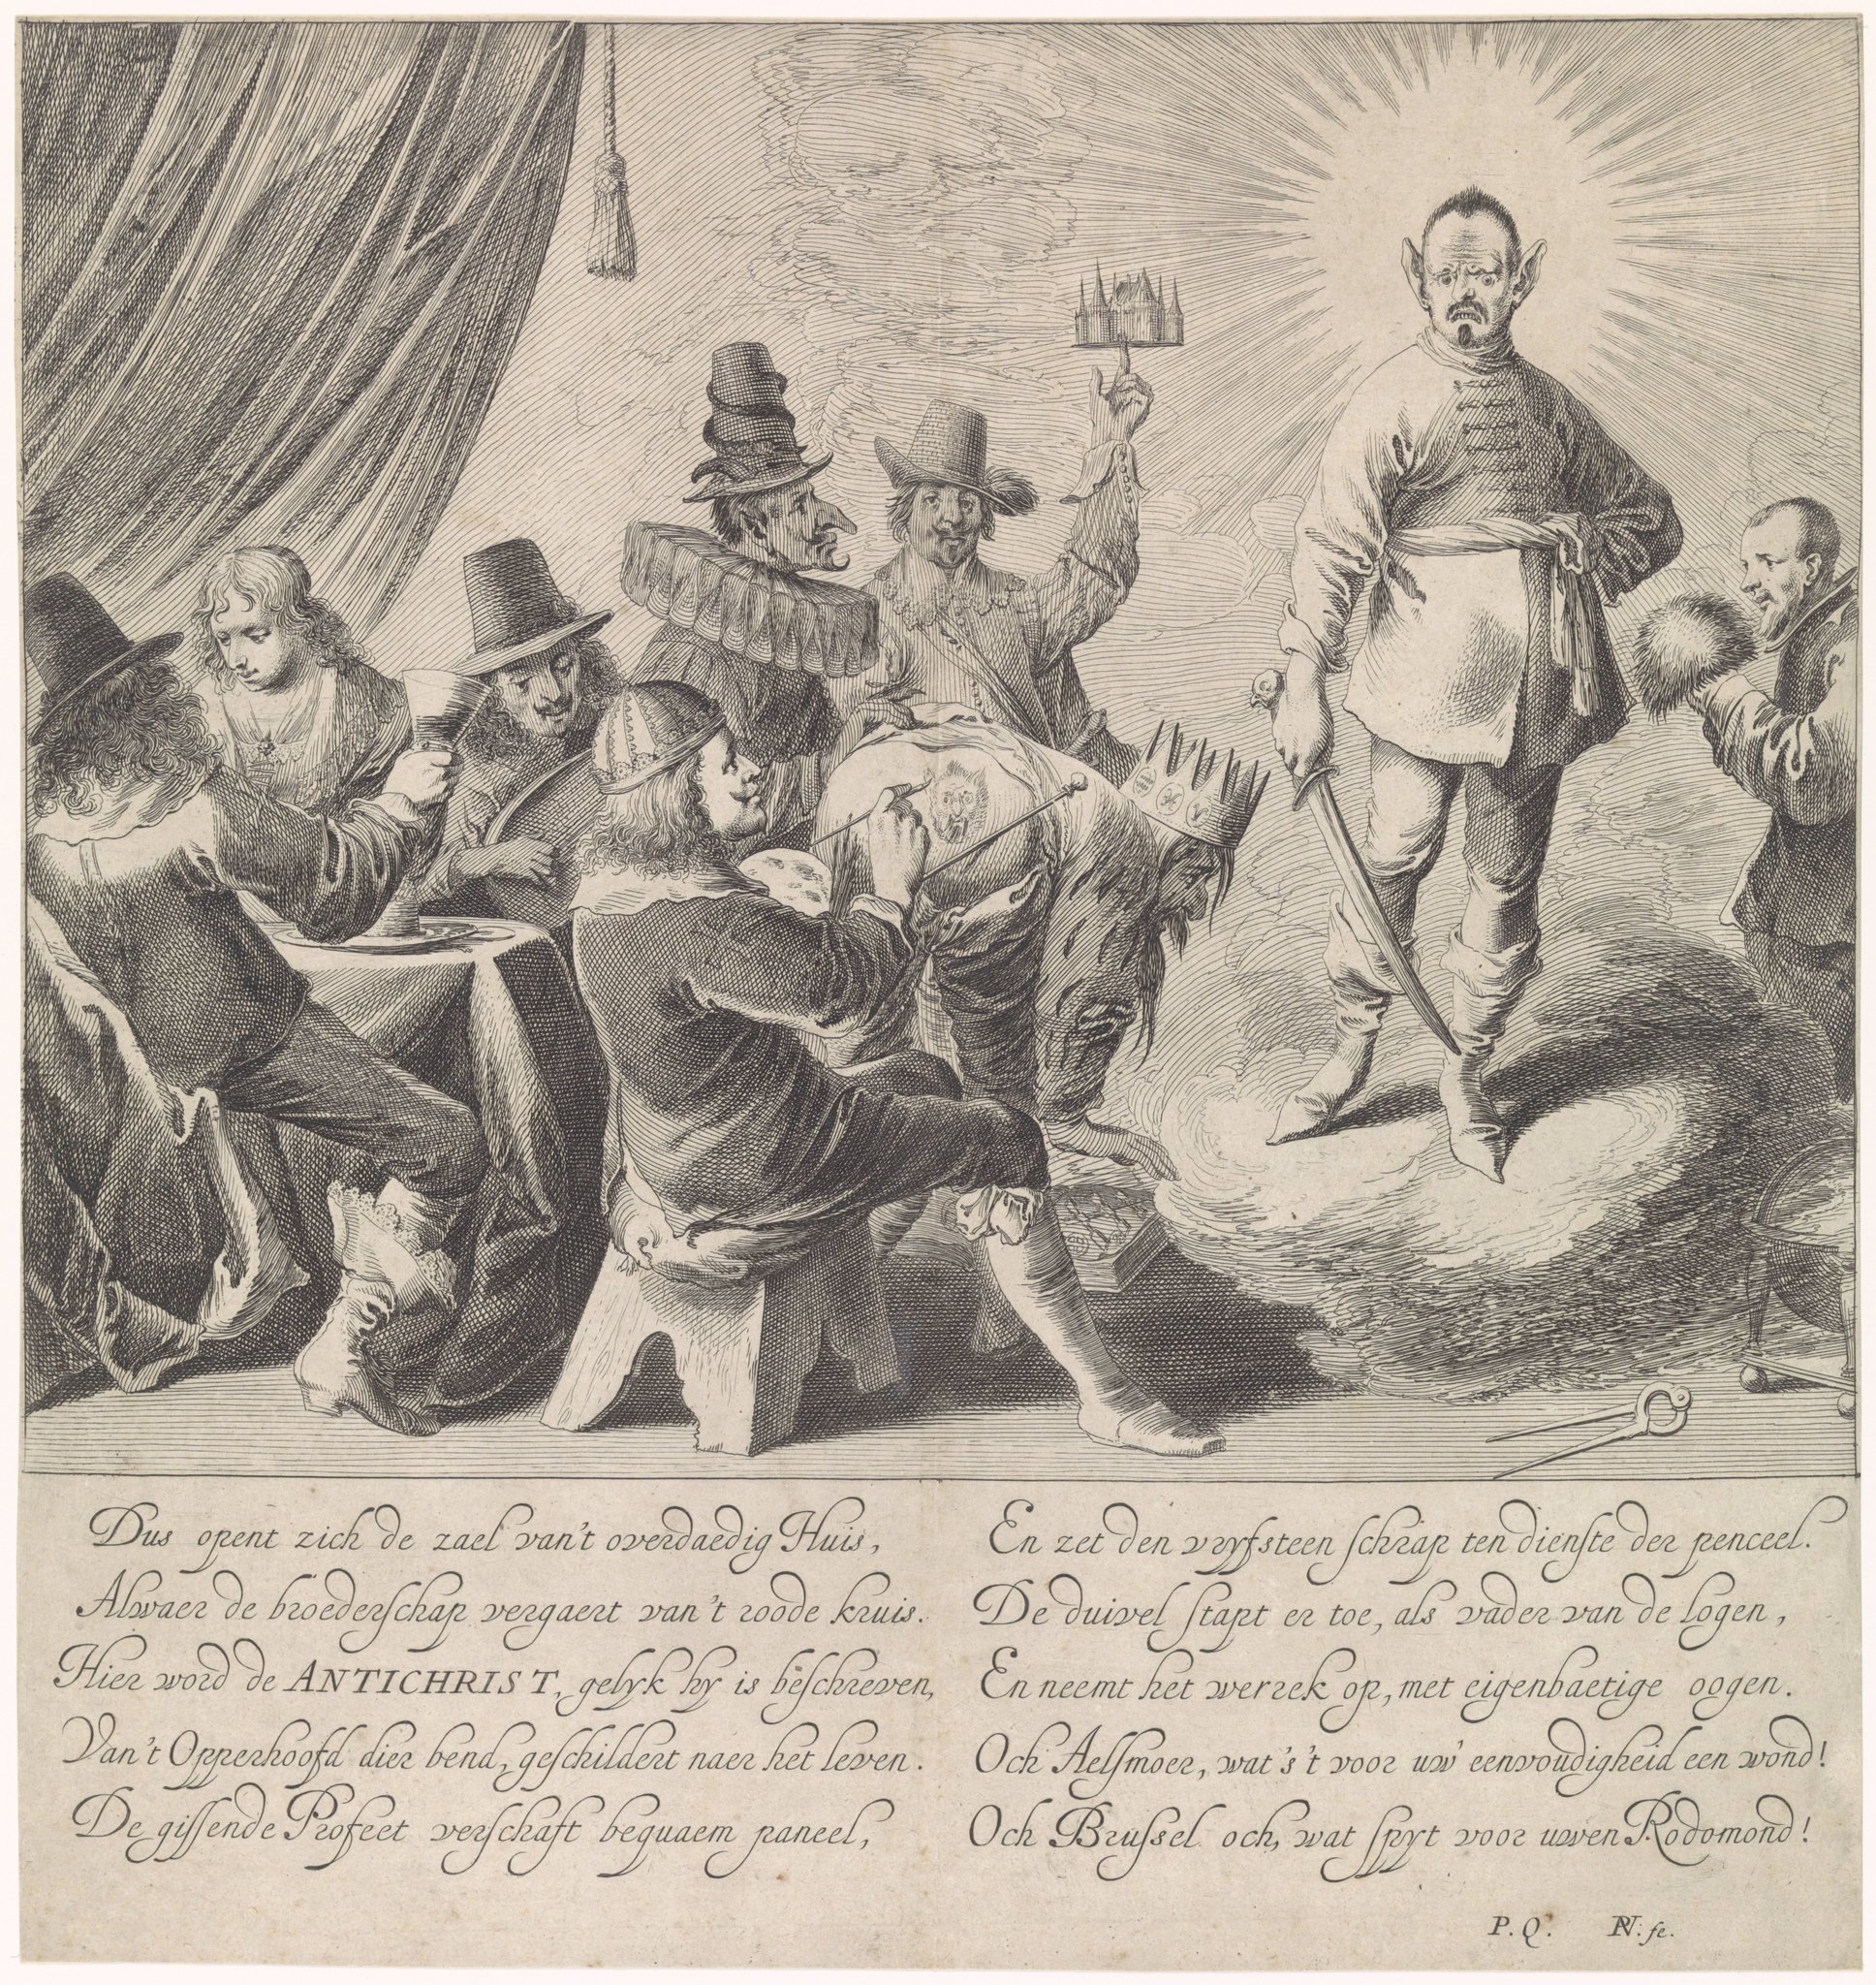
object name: print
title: Spotprent op de broederschap van het rode kruis [de Rozenkruisers]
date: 1623-1653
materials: paper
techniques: engraving, etching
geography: amsterdam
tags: (professional) organization of artists, caricature of painting (+ meetings ~ arts), antichrist, painter working from clothed model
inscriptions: collector's mark: Lugt 2166, collector's mark: Lugt 2760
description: Satire met het schilderen van de Antichrist, ca. 1650. Interieur van een herberg waarin een schilder het portret van de opgeroepen Antichrist of duivel schildert op het blote achterste van een voorover gebogen man met een kroon op het hoofd. De duivel staat op een rookwolk, hierbij een globe en tang. Links aan een tafel een man met een glas wijn, een luitspeler en een jonge vrouw. Achter de schilder een dwaas met een hoge hoed, grote kraag en grote neus. Daarachter staat een man met een model van een kasteel. Rechts kijkt een Hollandse matroos met bontmuts in de hand toe. In het onderschrift een vers van twee keer vijf regels. Het vers spreekt van een vergadering van het broederschap van het rode kruis [de Rozekruisers of Rozenkruisers], de kleding van twee van de personen is op de mouw versierd met een kruis. Waarschijnlijk heeft de voorstelling betrekking op de dichter Mattheus Gansneb Tengnagel.